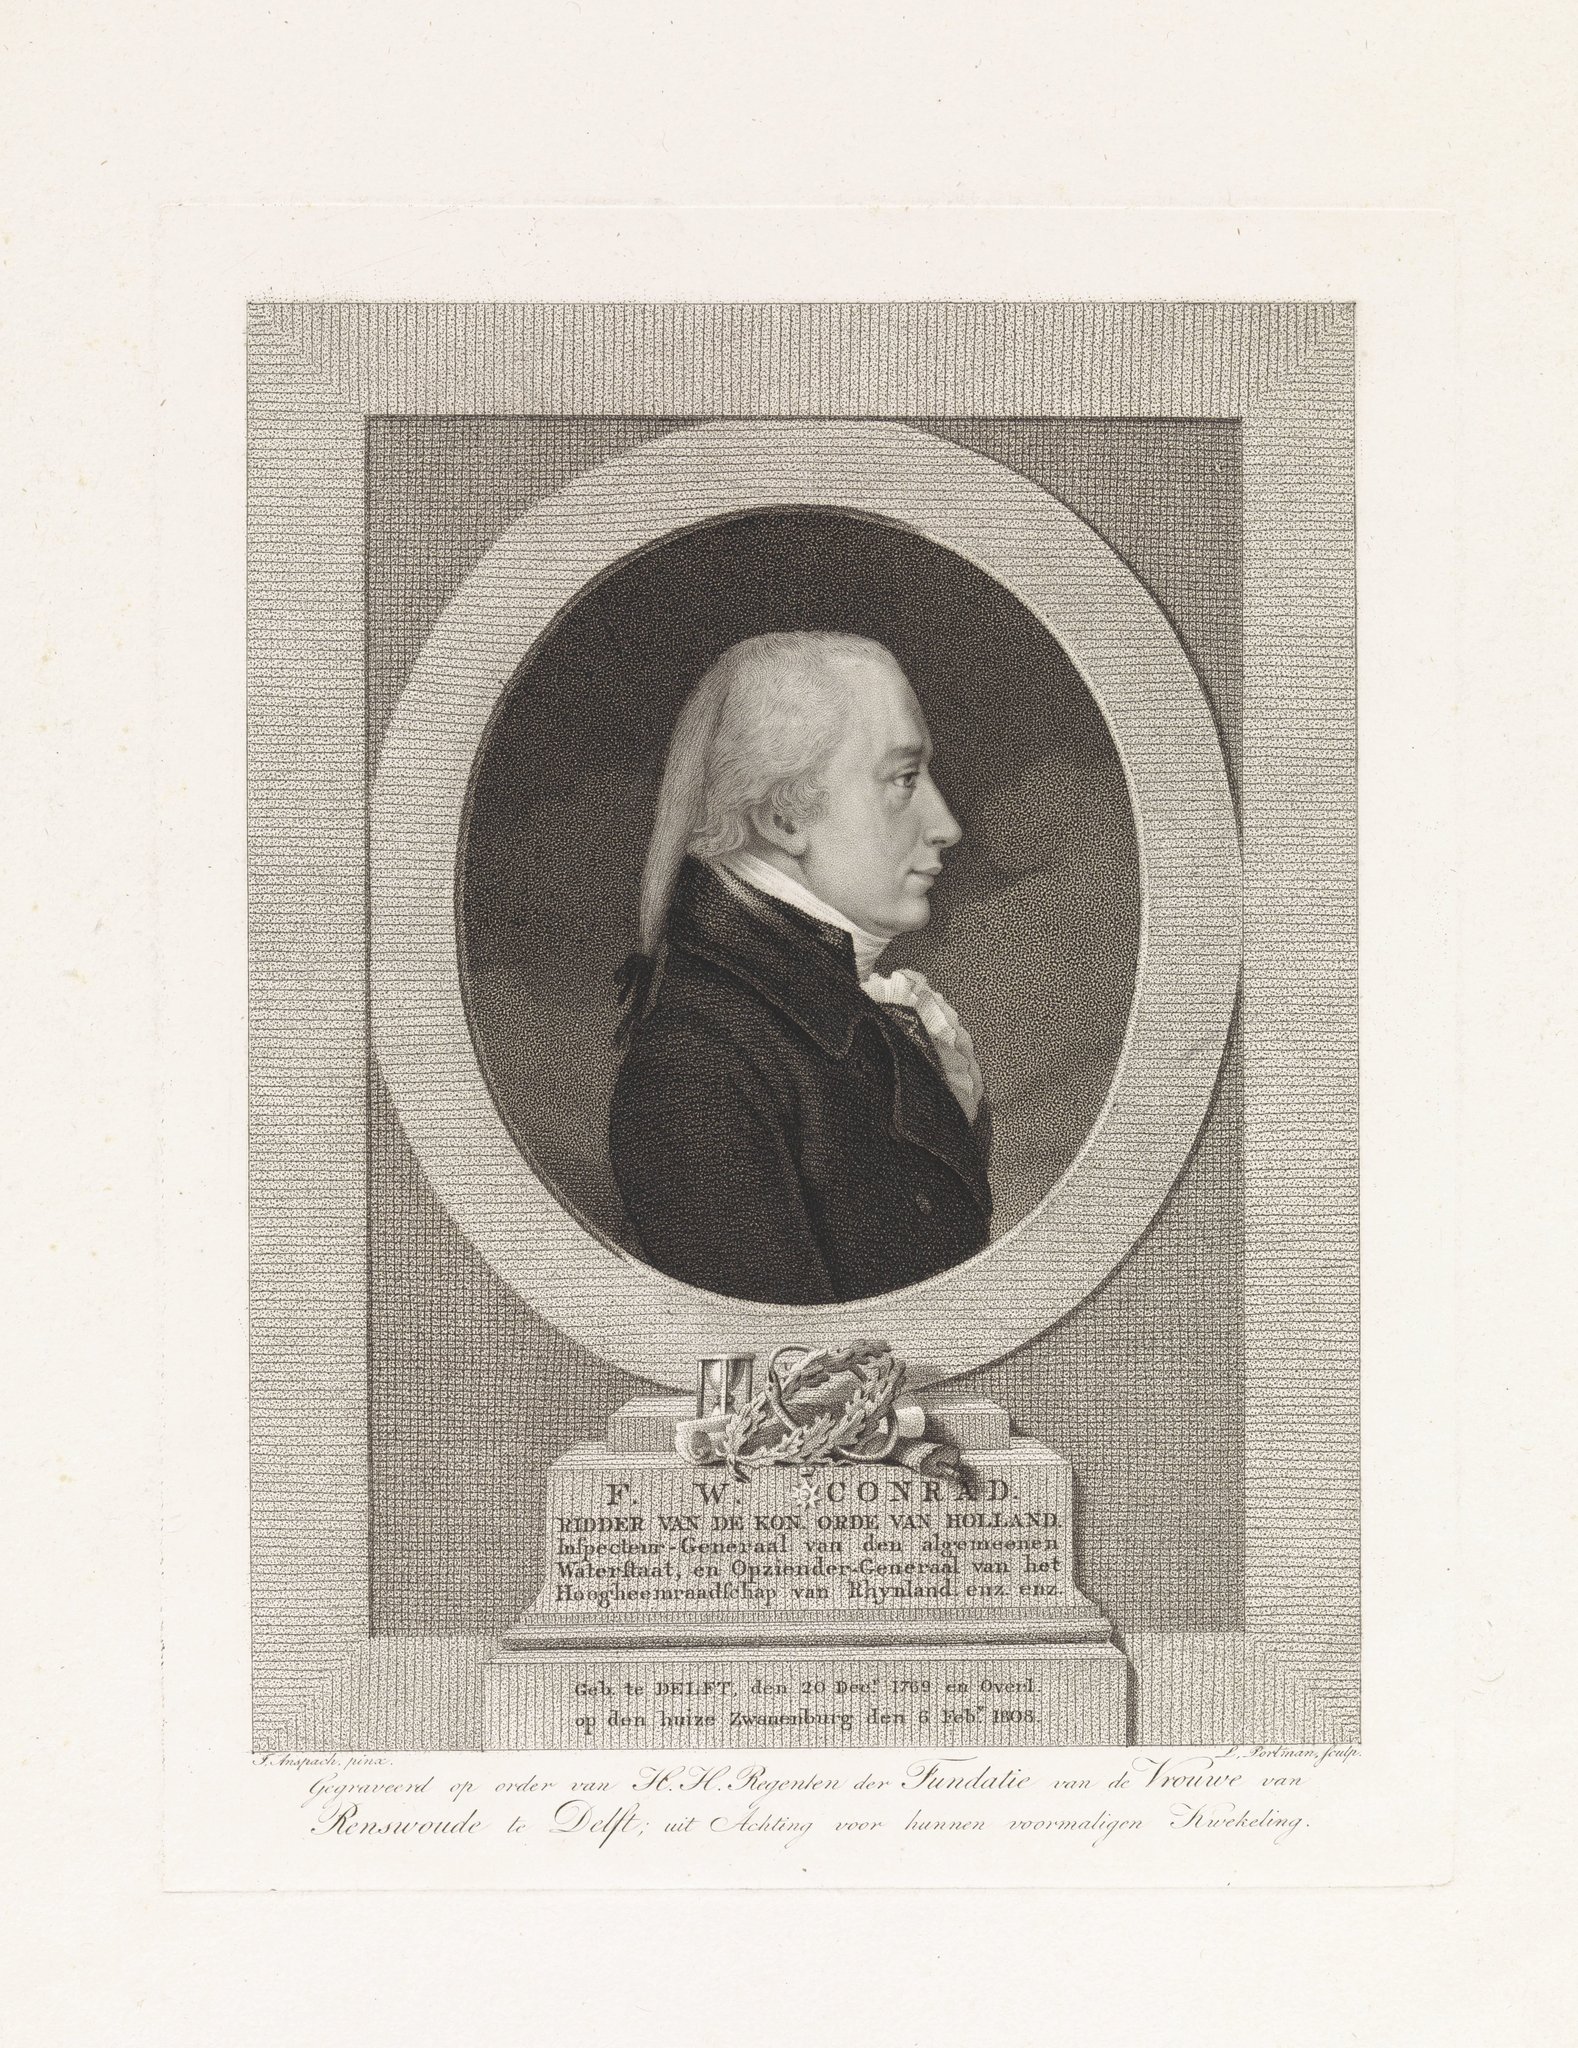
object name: print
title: Portret van Frederik Willem Conrad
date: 1808-1828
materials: paper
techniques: stippled etching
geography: delft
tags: frederik willem conrad (ii), knighthood order, hourglass, serpent ouroboros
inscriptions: collector's mark: Lugt 2228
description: Portret van Frederik Willem Conrad, ingenieur en inspecteur-generaal van Waterstaat. Op de piëdestal een zandloper, lauwerkrans, ouroboros (slang die in zijn eigen staart bijt) en het kruis van de Koninklijke Orde van Holland.